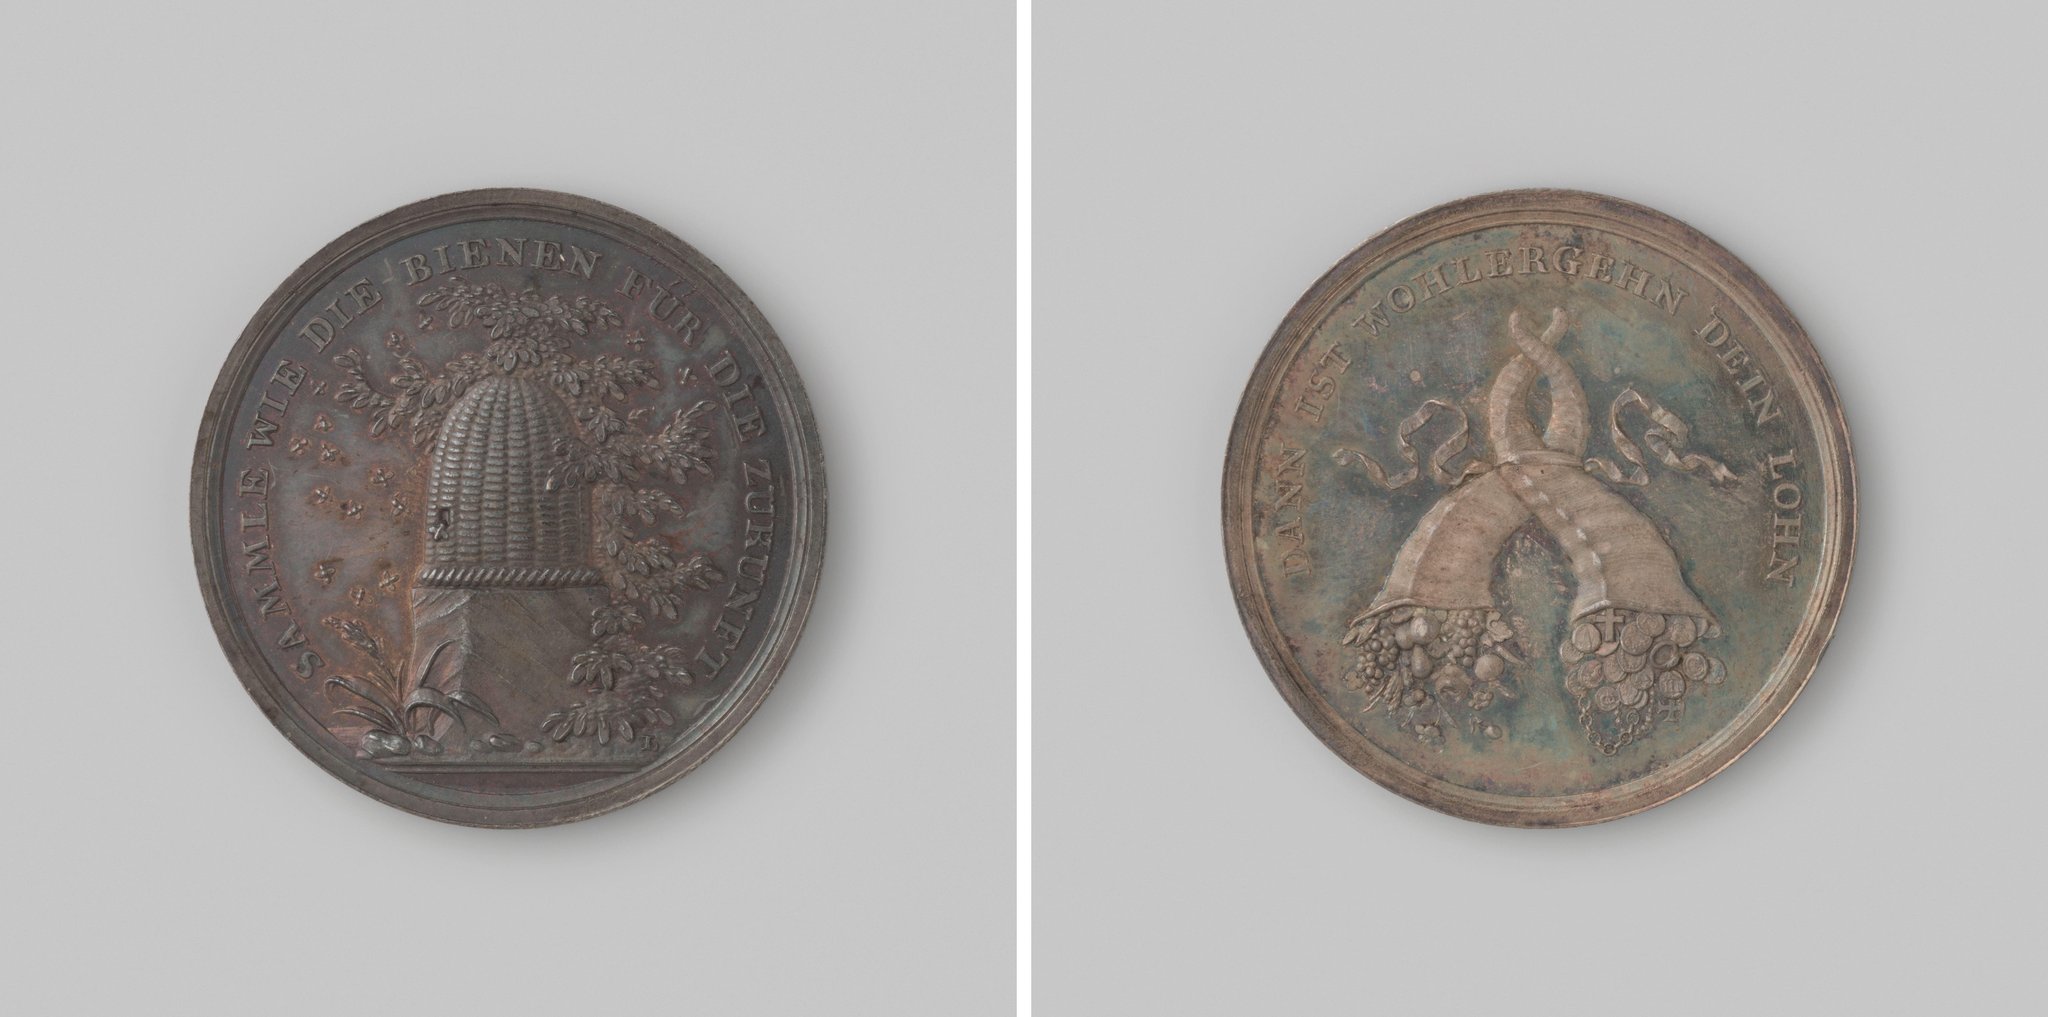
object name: history medal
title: Gedenkpenning voor de vlijtige jeugd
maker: daniel friedrich loos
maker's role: medailleur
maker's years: 1735-1819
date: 1775-1825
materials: silver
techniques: striking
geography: berlin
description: Zilveren penning, op de voorzijde een bijenkorf met omschrift, op de keerzijde twee samengestrikte hoorns des overvloeds met omschrift.